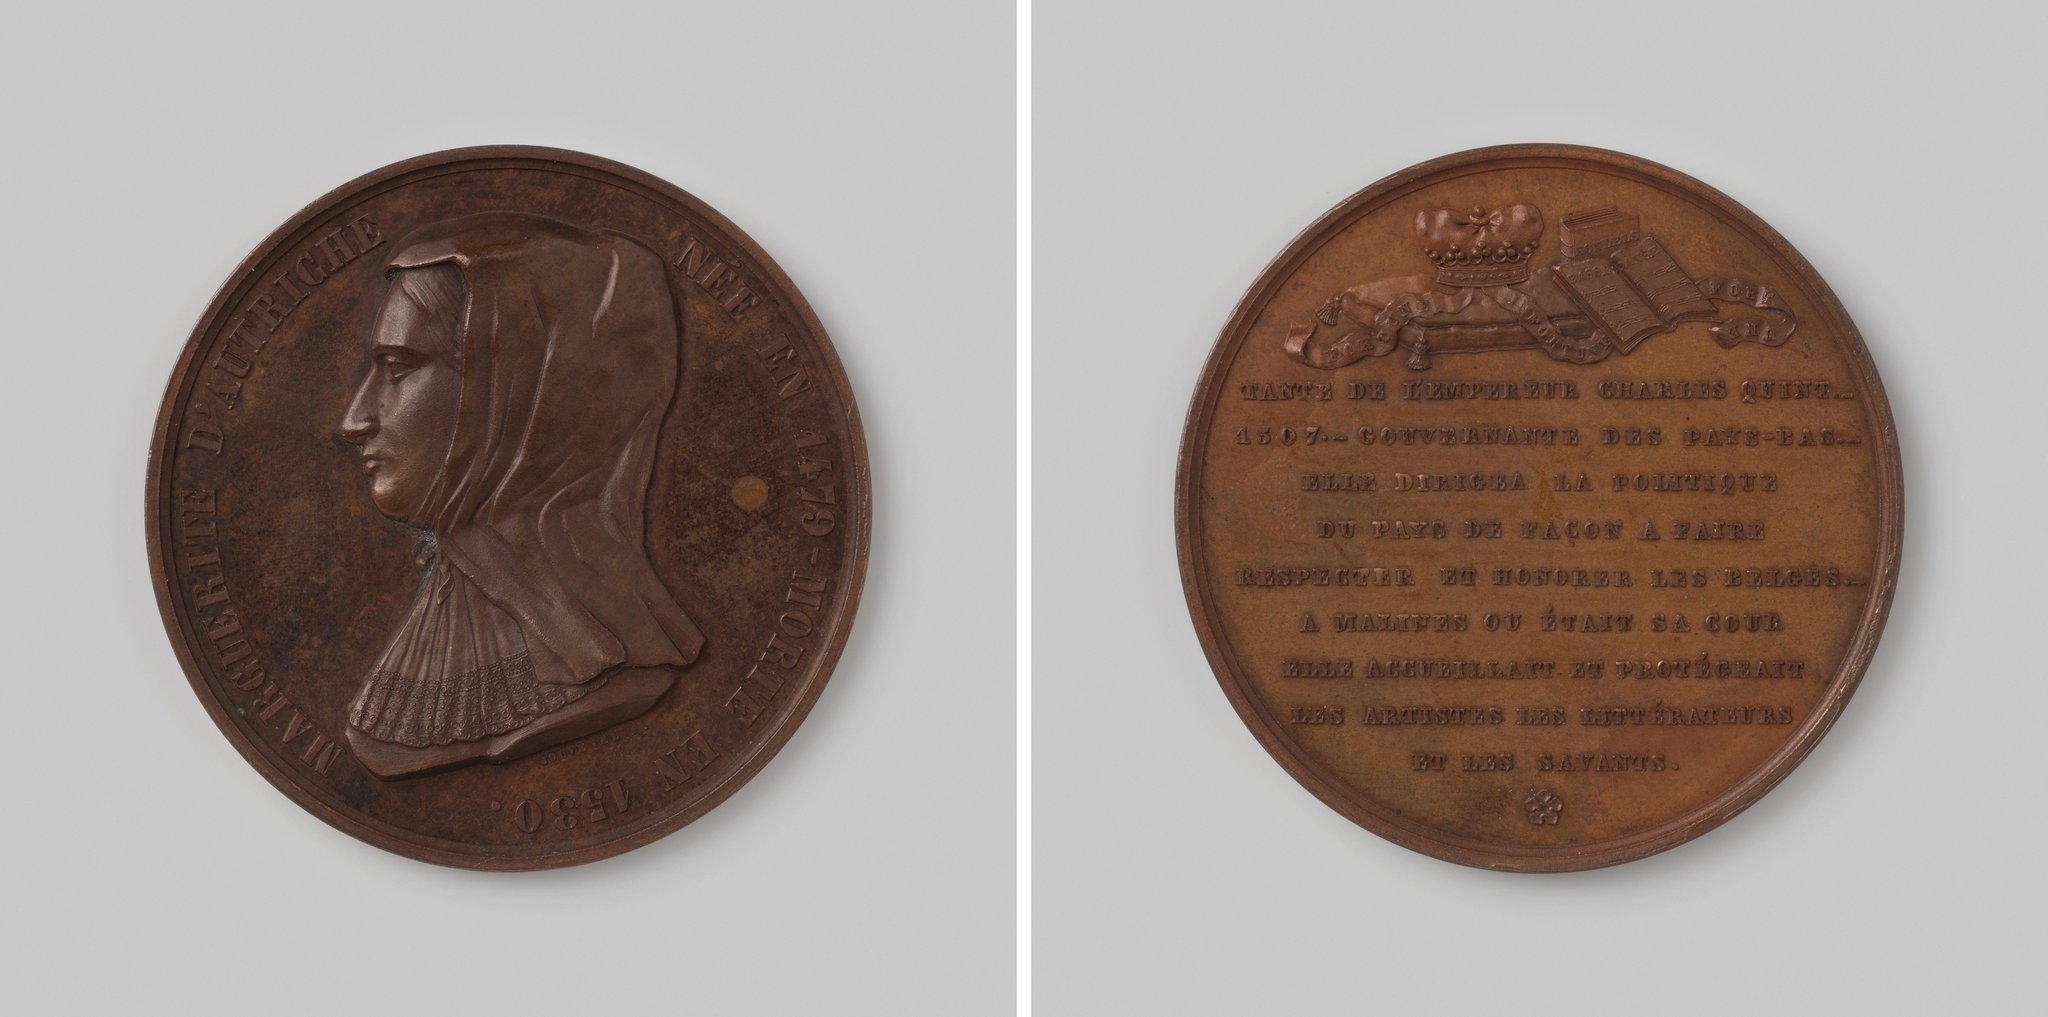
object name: history medal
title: Margaretha van Oostenrijk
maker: adolphe jouvenel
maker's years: 1798-1867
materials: copper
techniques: striking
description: Bronzen penning, op de voorzijde het borstbeeld van Magaretha naar links met omschrift, op de keerzijde een kroon met linten en twee boeken op een kussen, waaronder negen regels tekst.